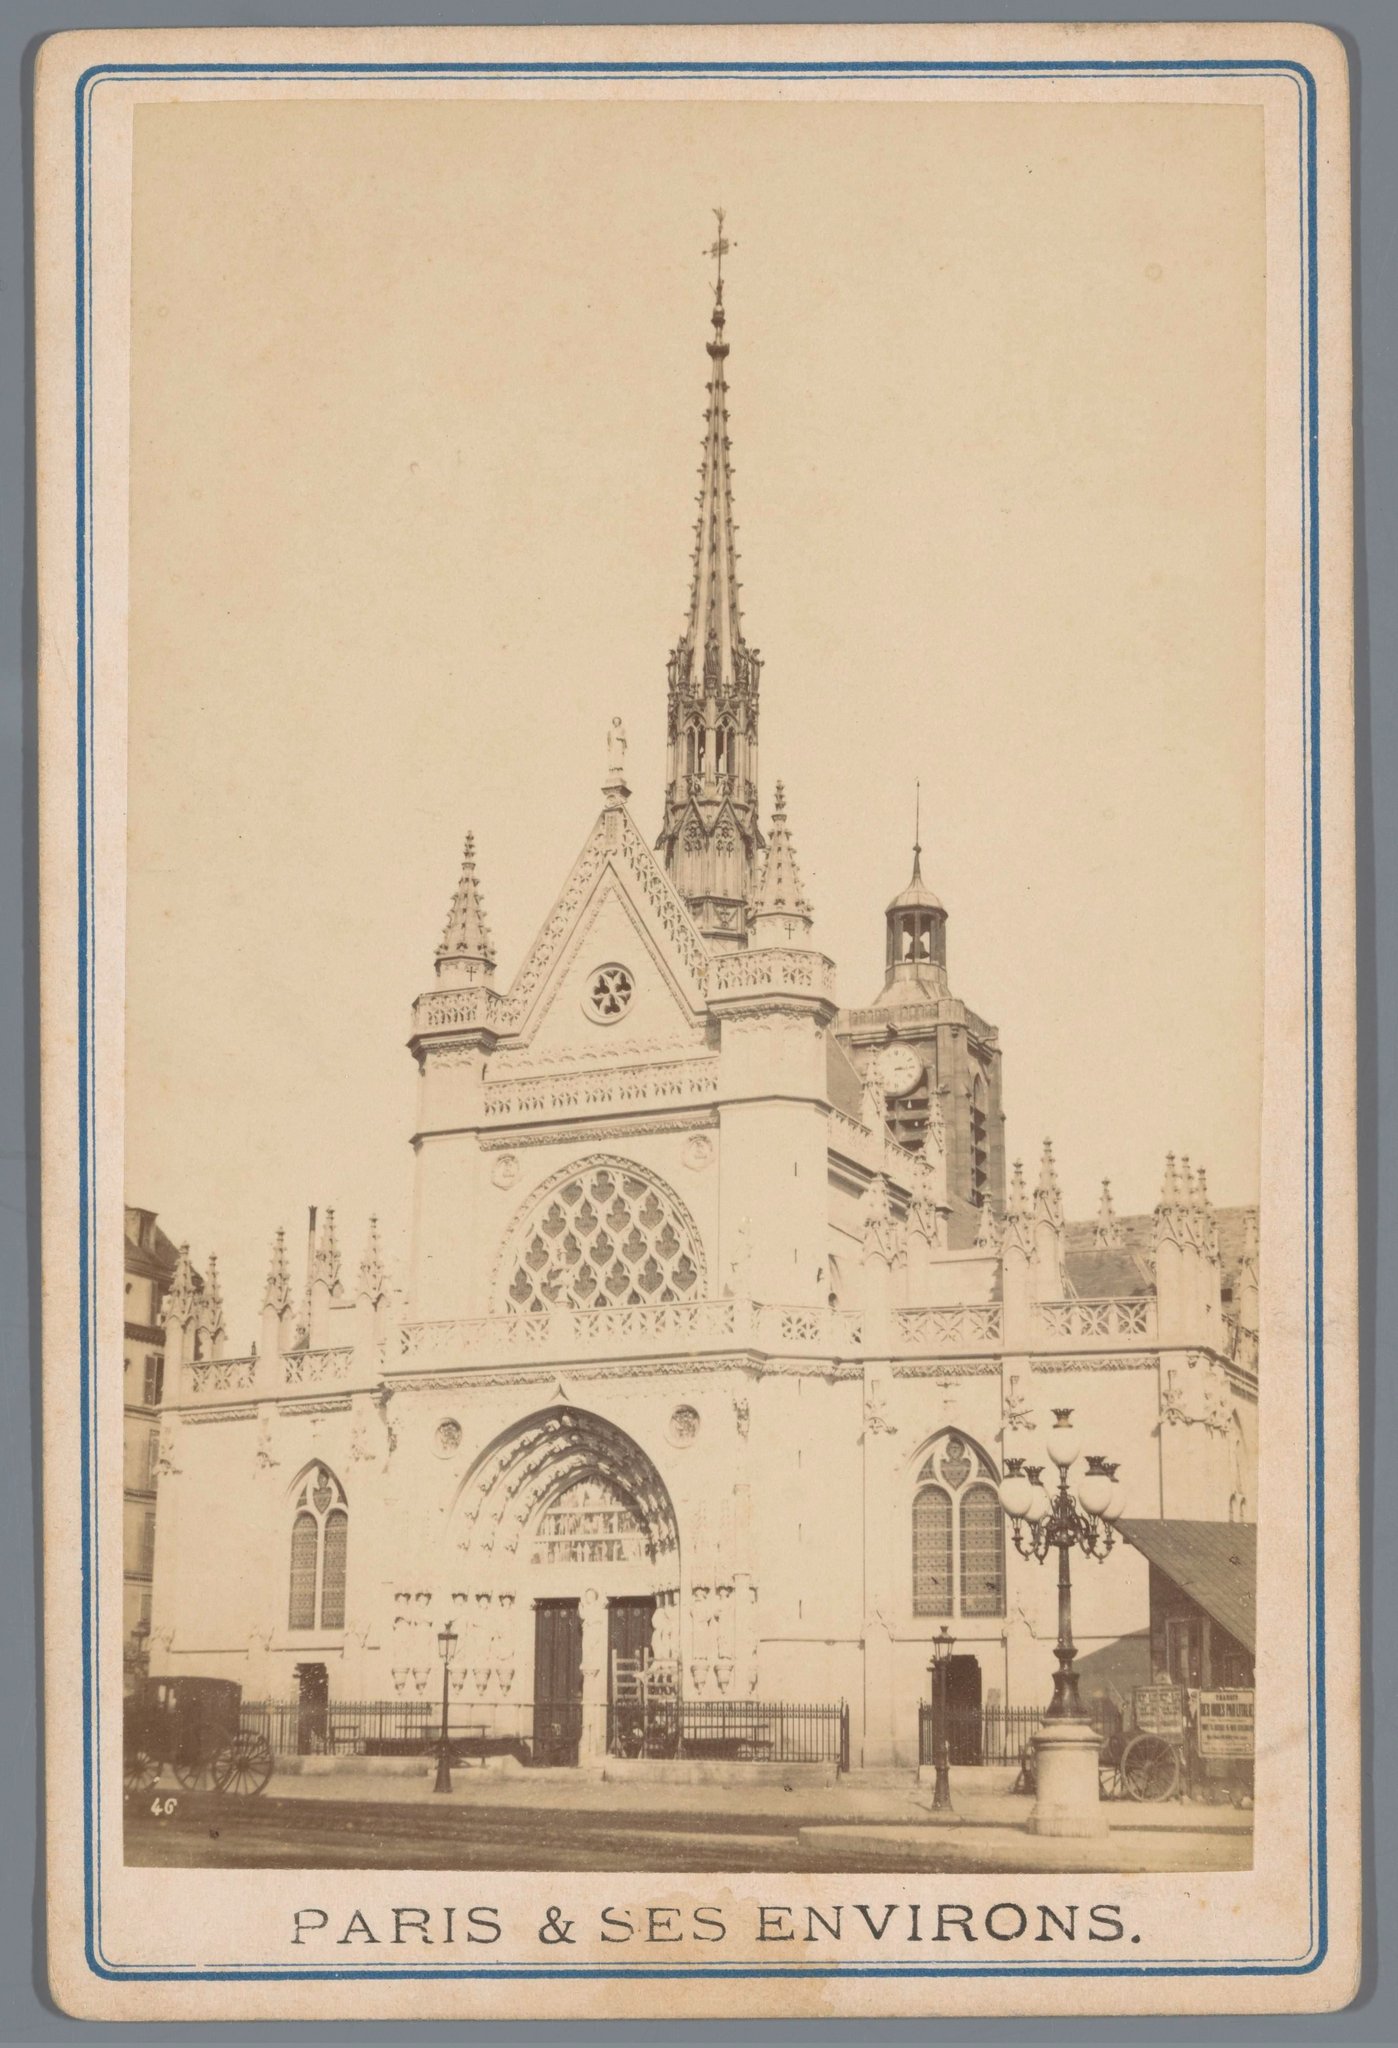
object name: cabinet photograph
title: Paris & ses environs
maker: Anonymous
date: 1865-1875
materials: cardboard, photographic support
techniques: albumen print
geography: paris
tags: church (exterior), façade (of house or building)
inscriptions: inscription: ‘St Laurent’